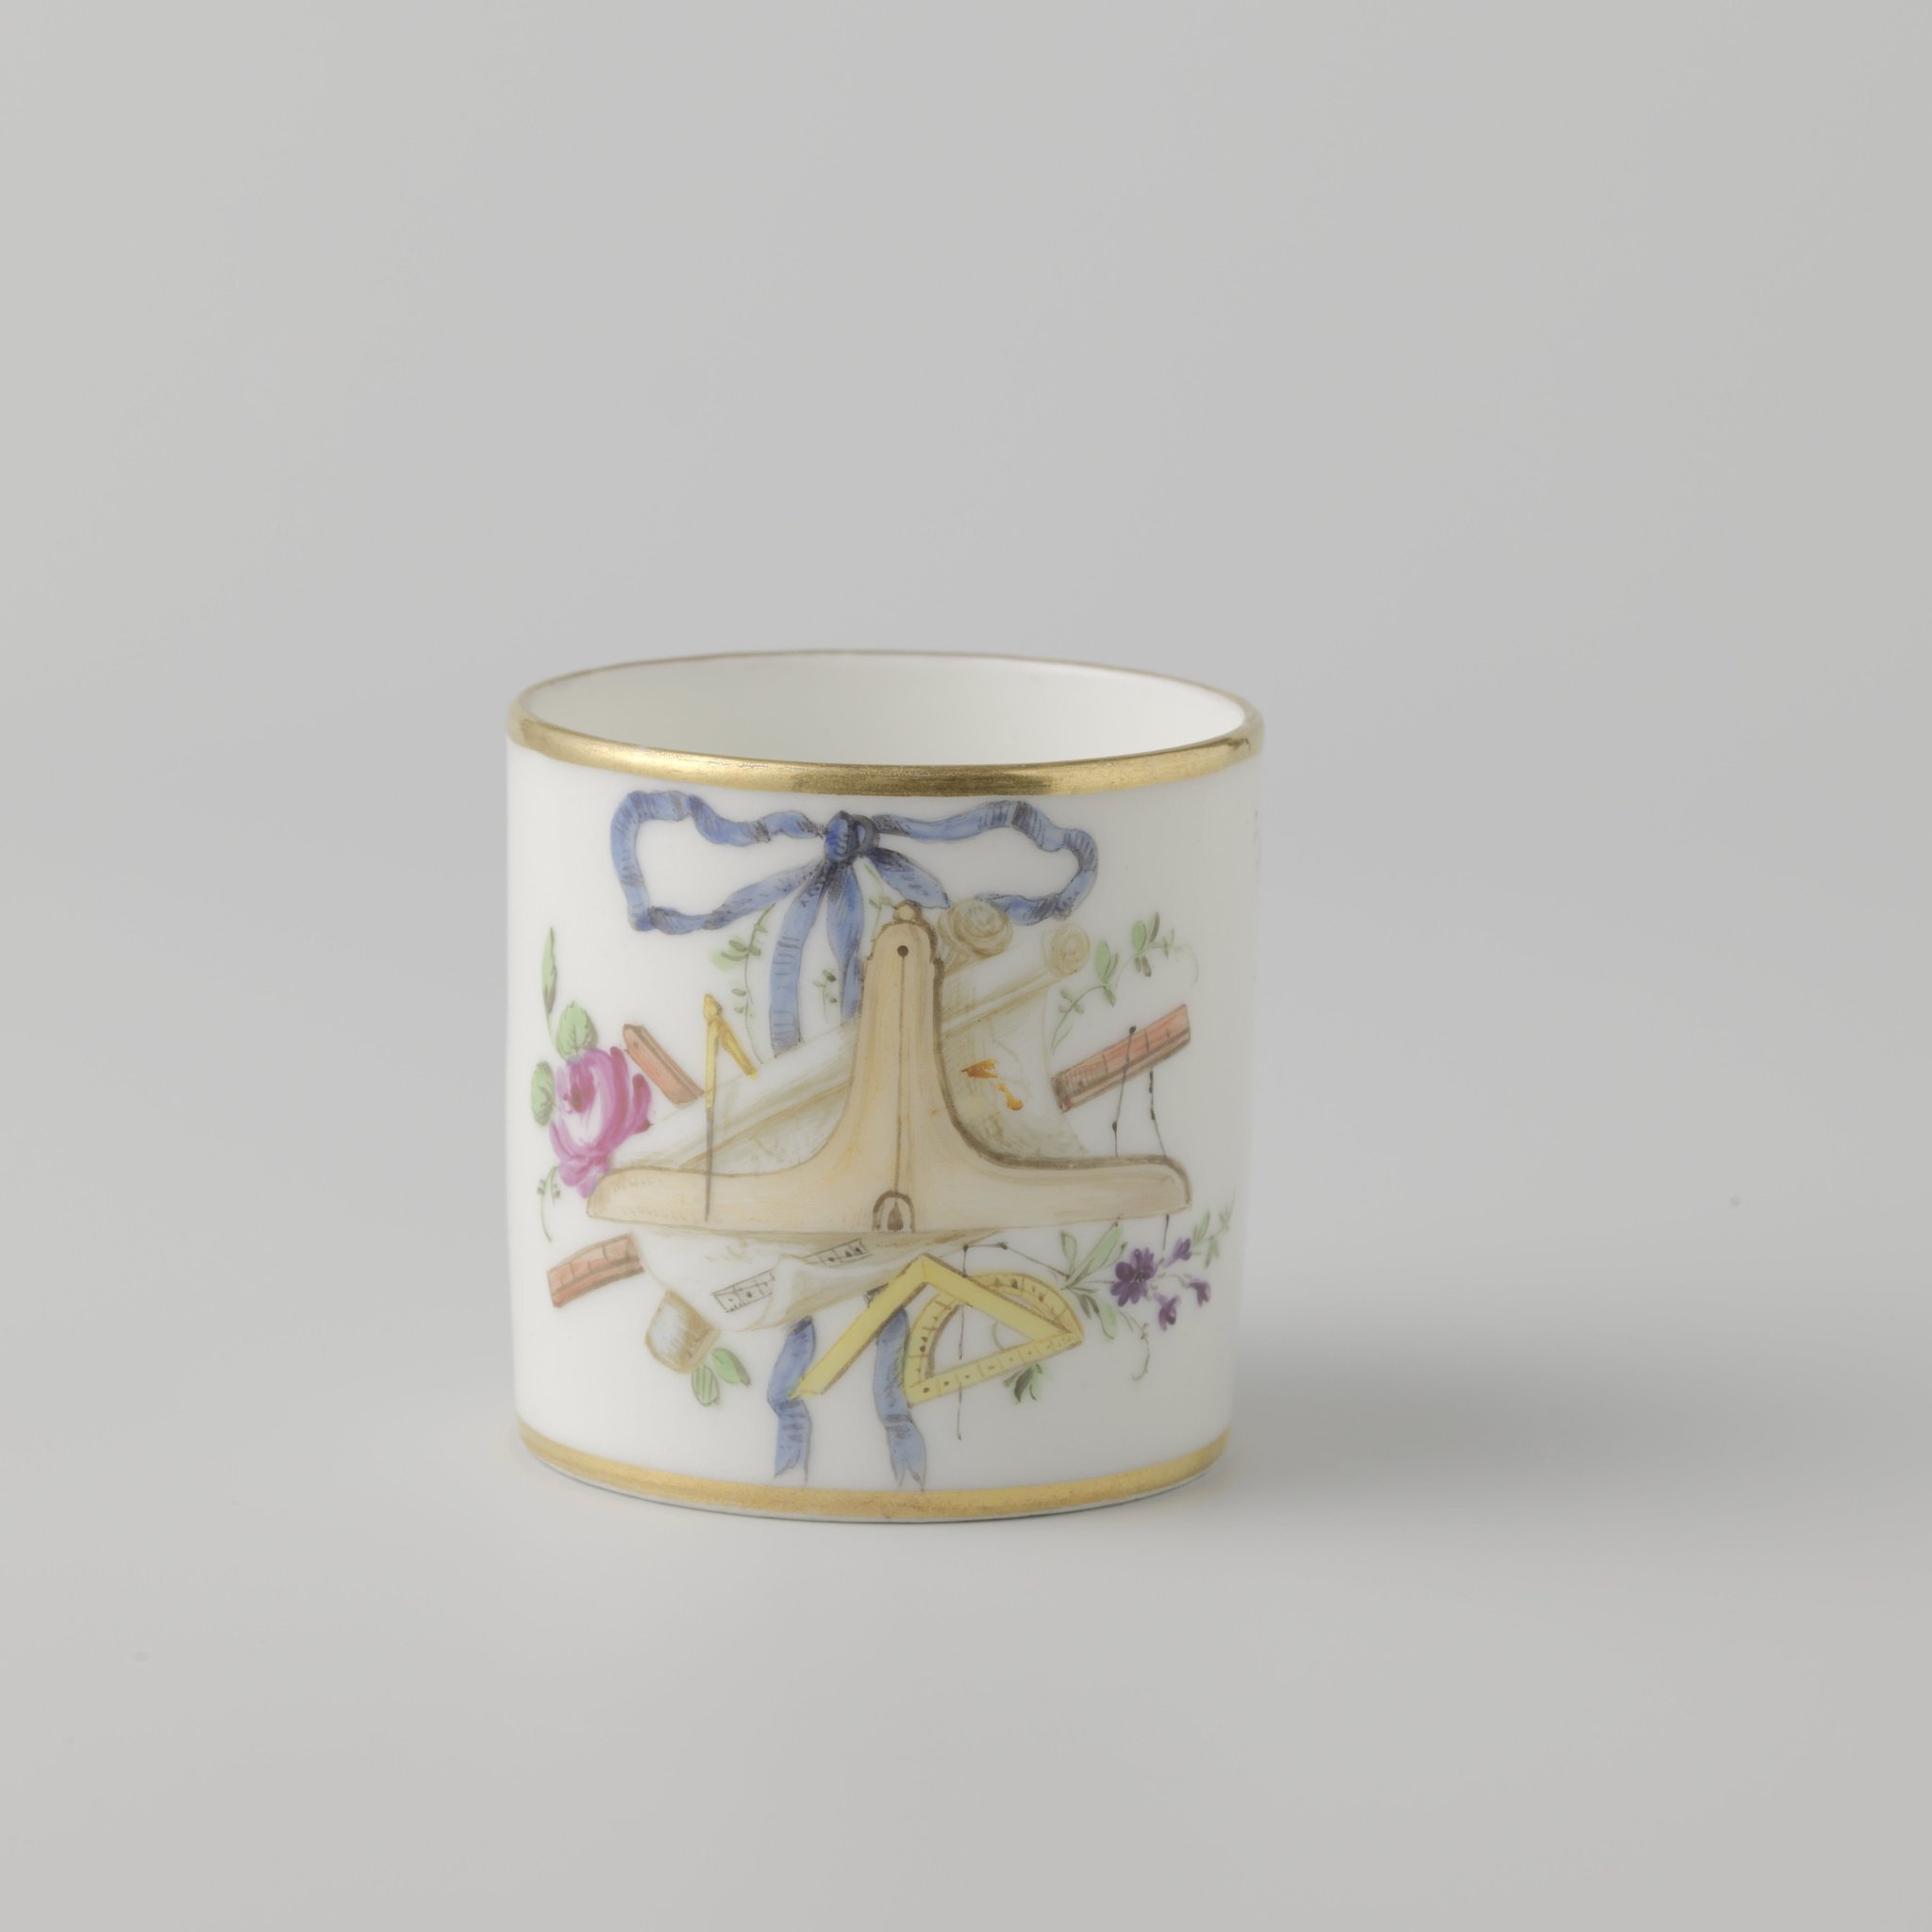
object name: cup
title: Theekop met decoratie van trofeeën aan gestrikte linten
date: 1809-1814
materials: porcelain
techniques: painted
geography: nieuwer-amstel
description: Theeservies bestaande uit een theepot, een suikerpot, een spoelkom en twaalf koppen en schotels veelkleurig beschilderd met trofeeën hangend aan blauwe strikken. De trofeeën hebben betrekking op diverse beroepen. Gemerkt in zwart: Amstel (de suikerpot Amstel N. 805 en ingegrift A). Verschillende ingegrifte merken in de koppen en schotels.